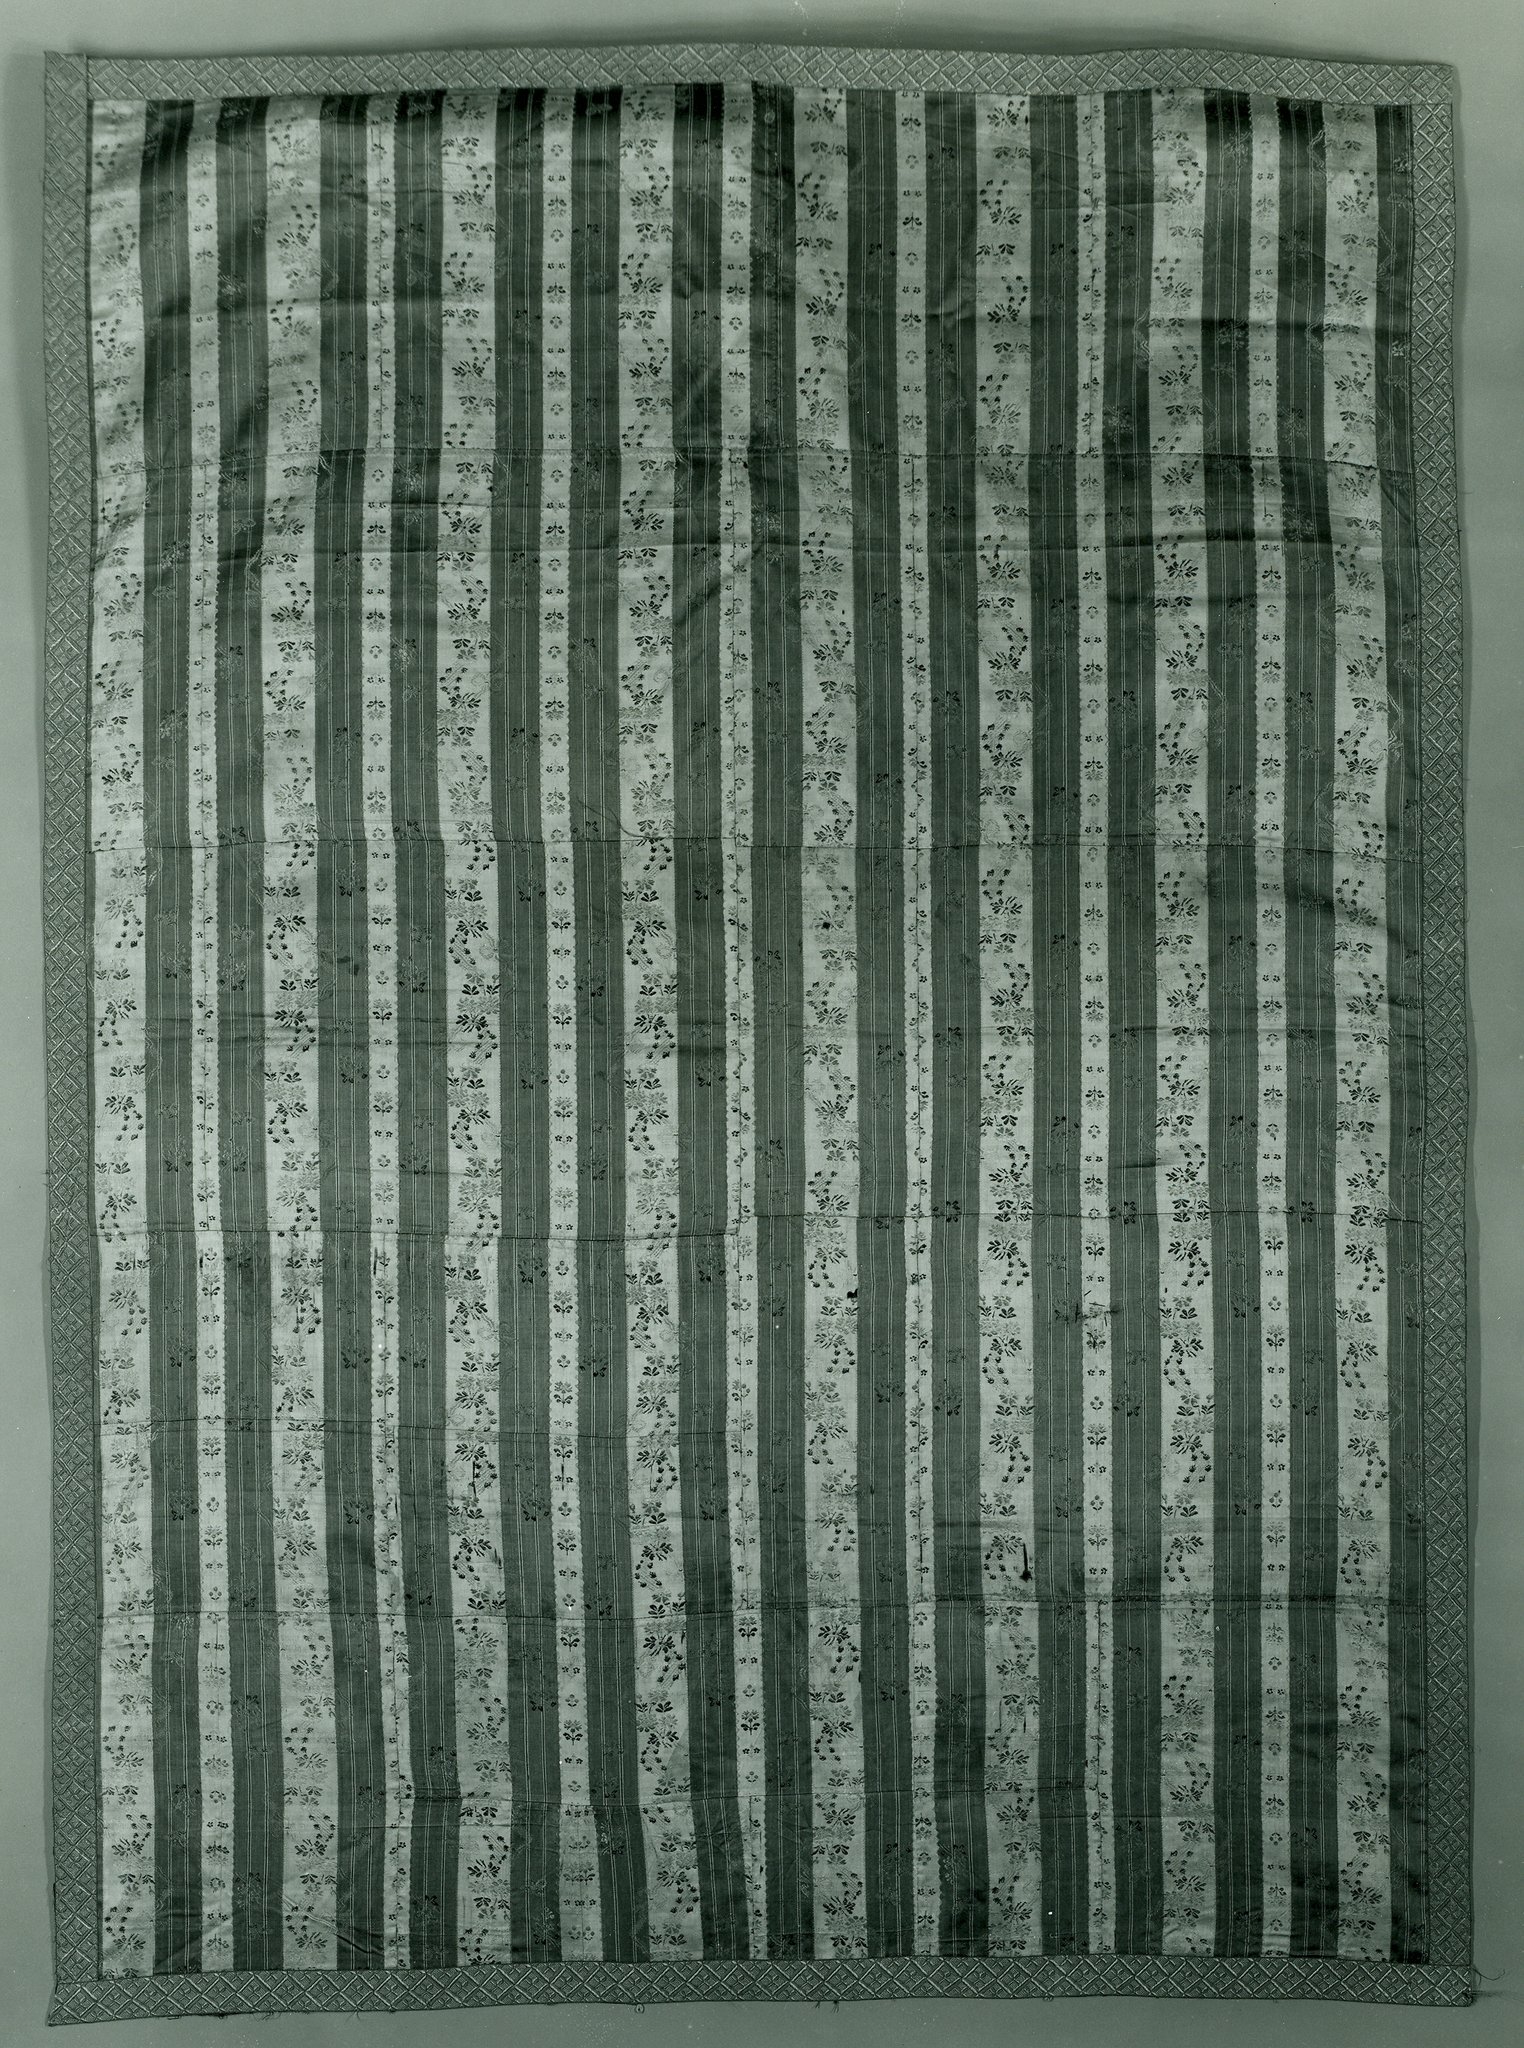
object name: textile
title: Large cover or Hanging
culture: spanish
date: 1767-1800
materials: cotton, ink, silk, wool